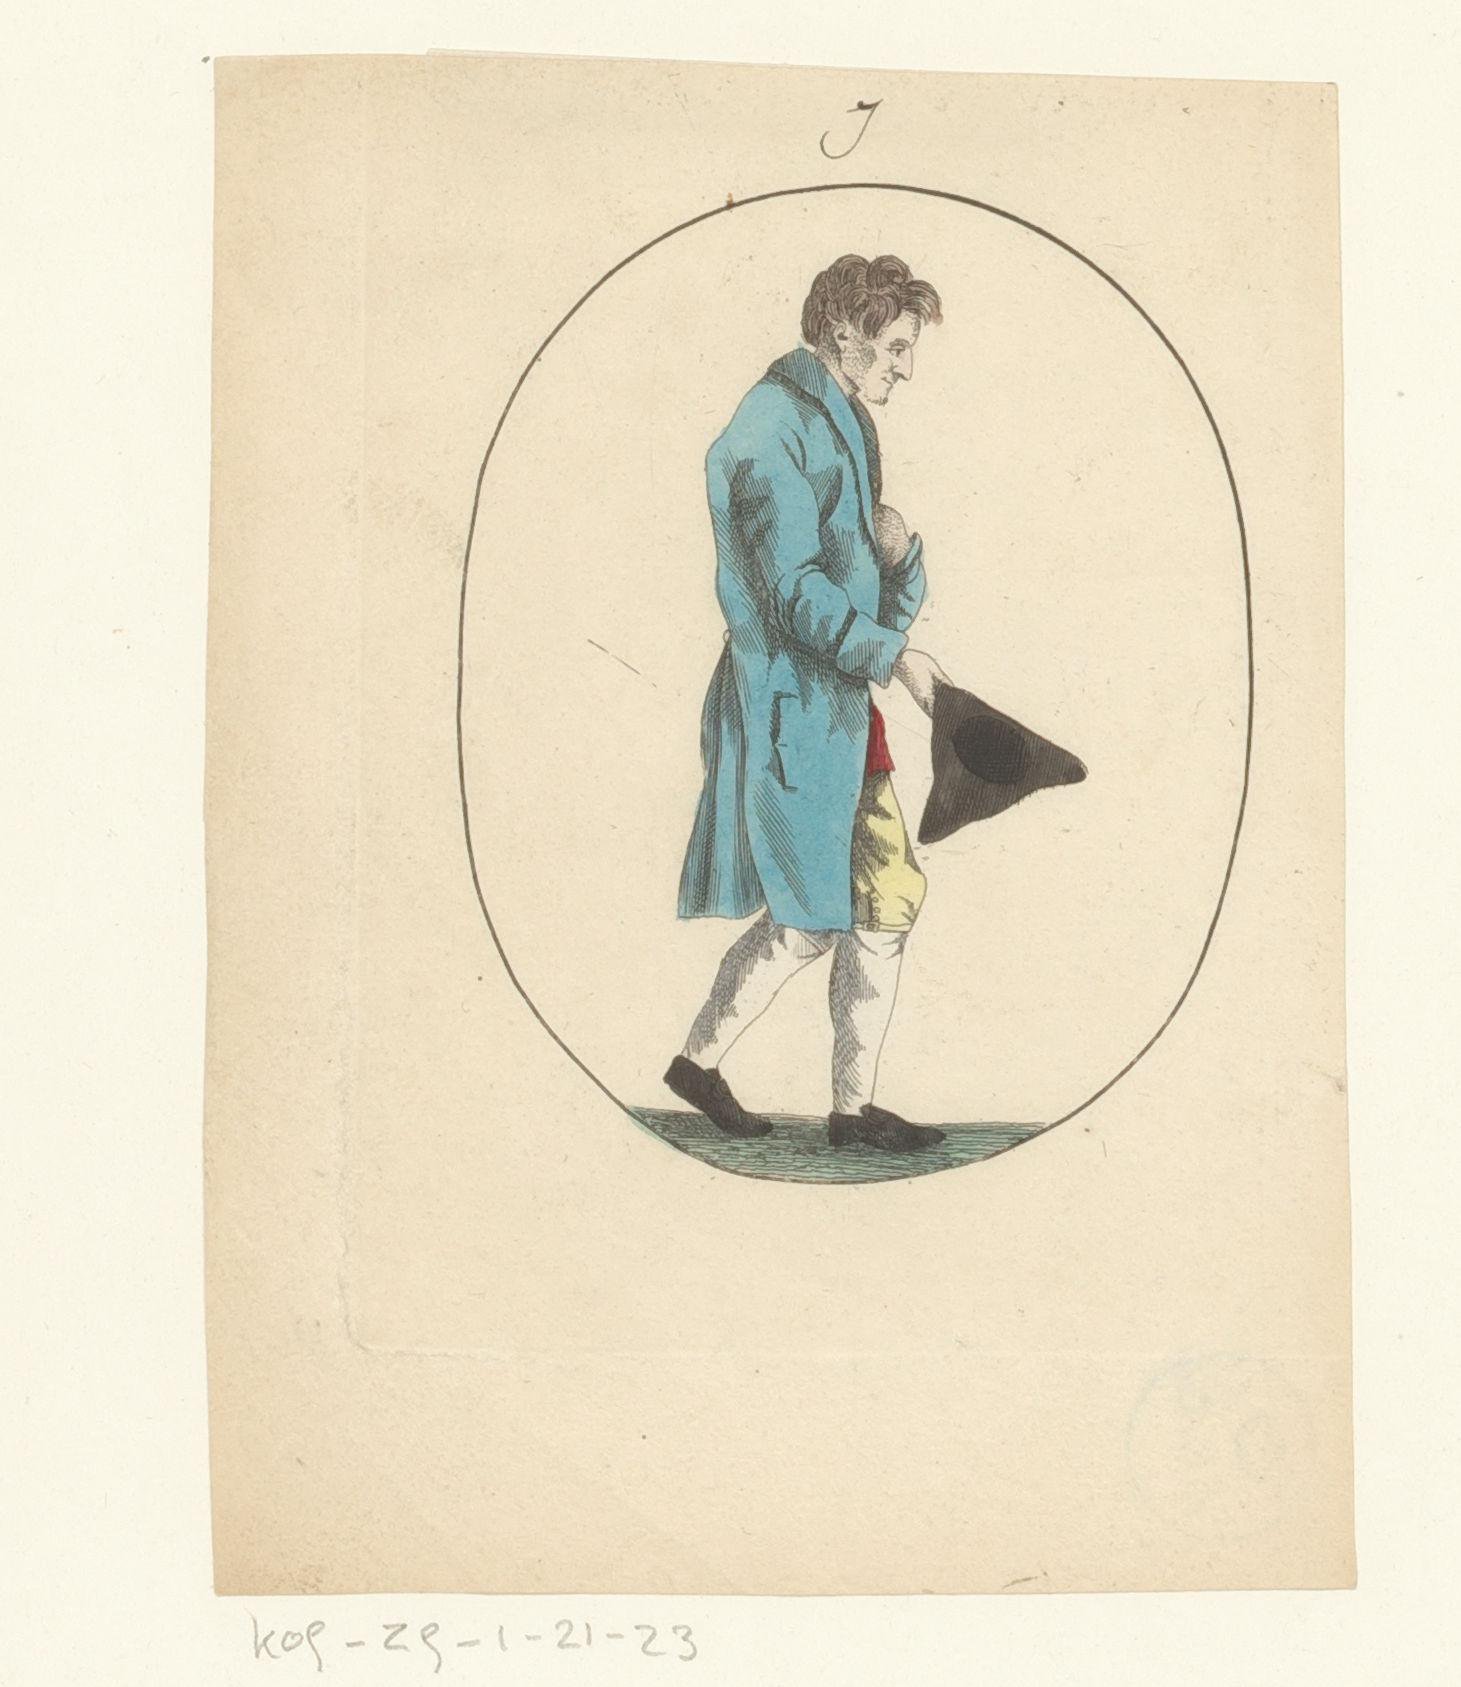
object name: print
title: Man met steek in zijn hand en hand in zijn jas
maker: Anonymous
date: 1750-1849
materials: paper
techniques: etching, hand coloring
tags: standing figure (+ sideview, profile), head-gear: tricorn, coat, historical costume, contemplation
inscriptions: collector's mark: Lugt 1641, stamp, collector's mark: Lugt 1641a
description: Bovenaan genummerd: 7. Onderwerpsrubrieken binnen de Atlas Zeden en Gewoonten: Zeden en Gewoonten in Engeren Zin, De Kleeding, Kleederdrachten (tijdvakken), De 18de eeuw (de pruikentijd). Mannen en vrouwen.